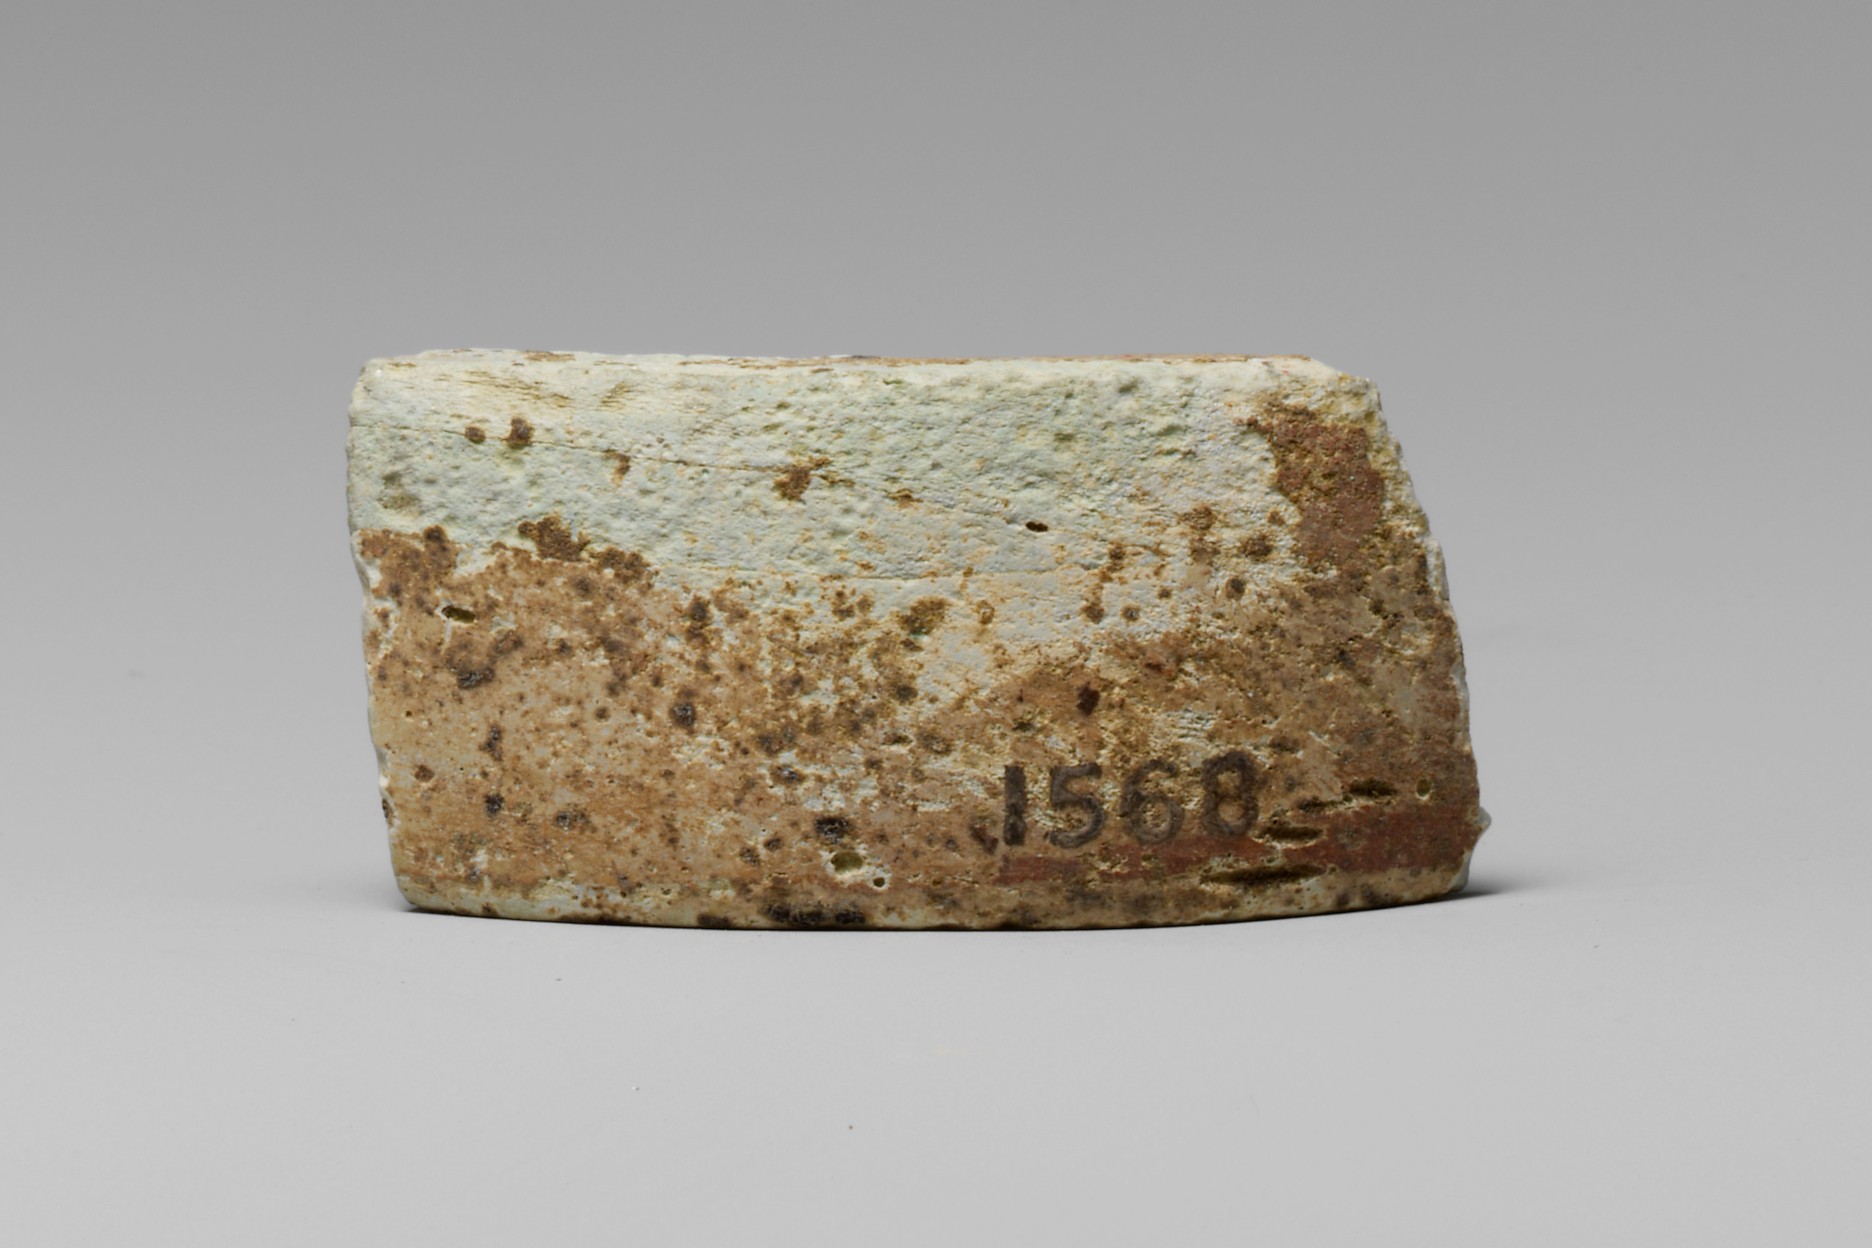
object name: vase fragment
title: Faience handle of a vase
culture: cypriot or egyptian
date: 1300-1101 BCE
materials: faience